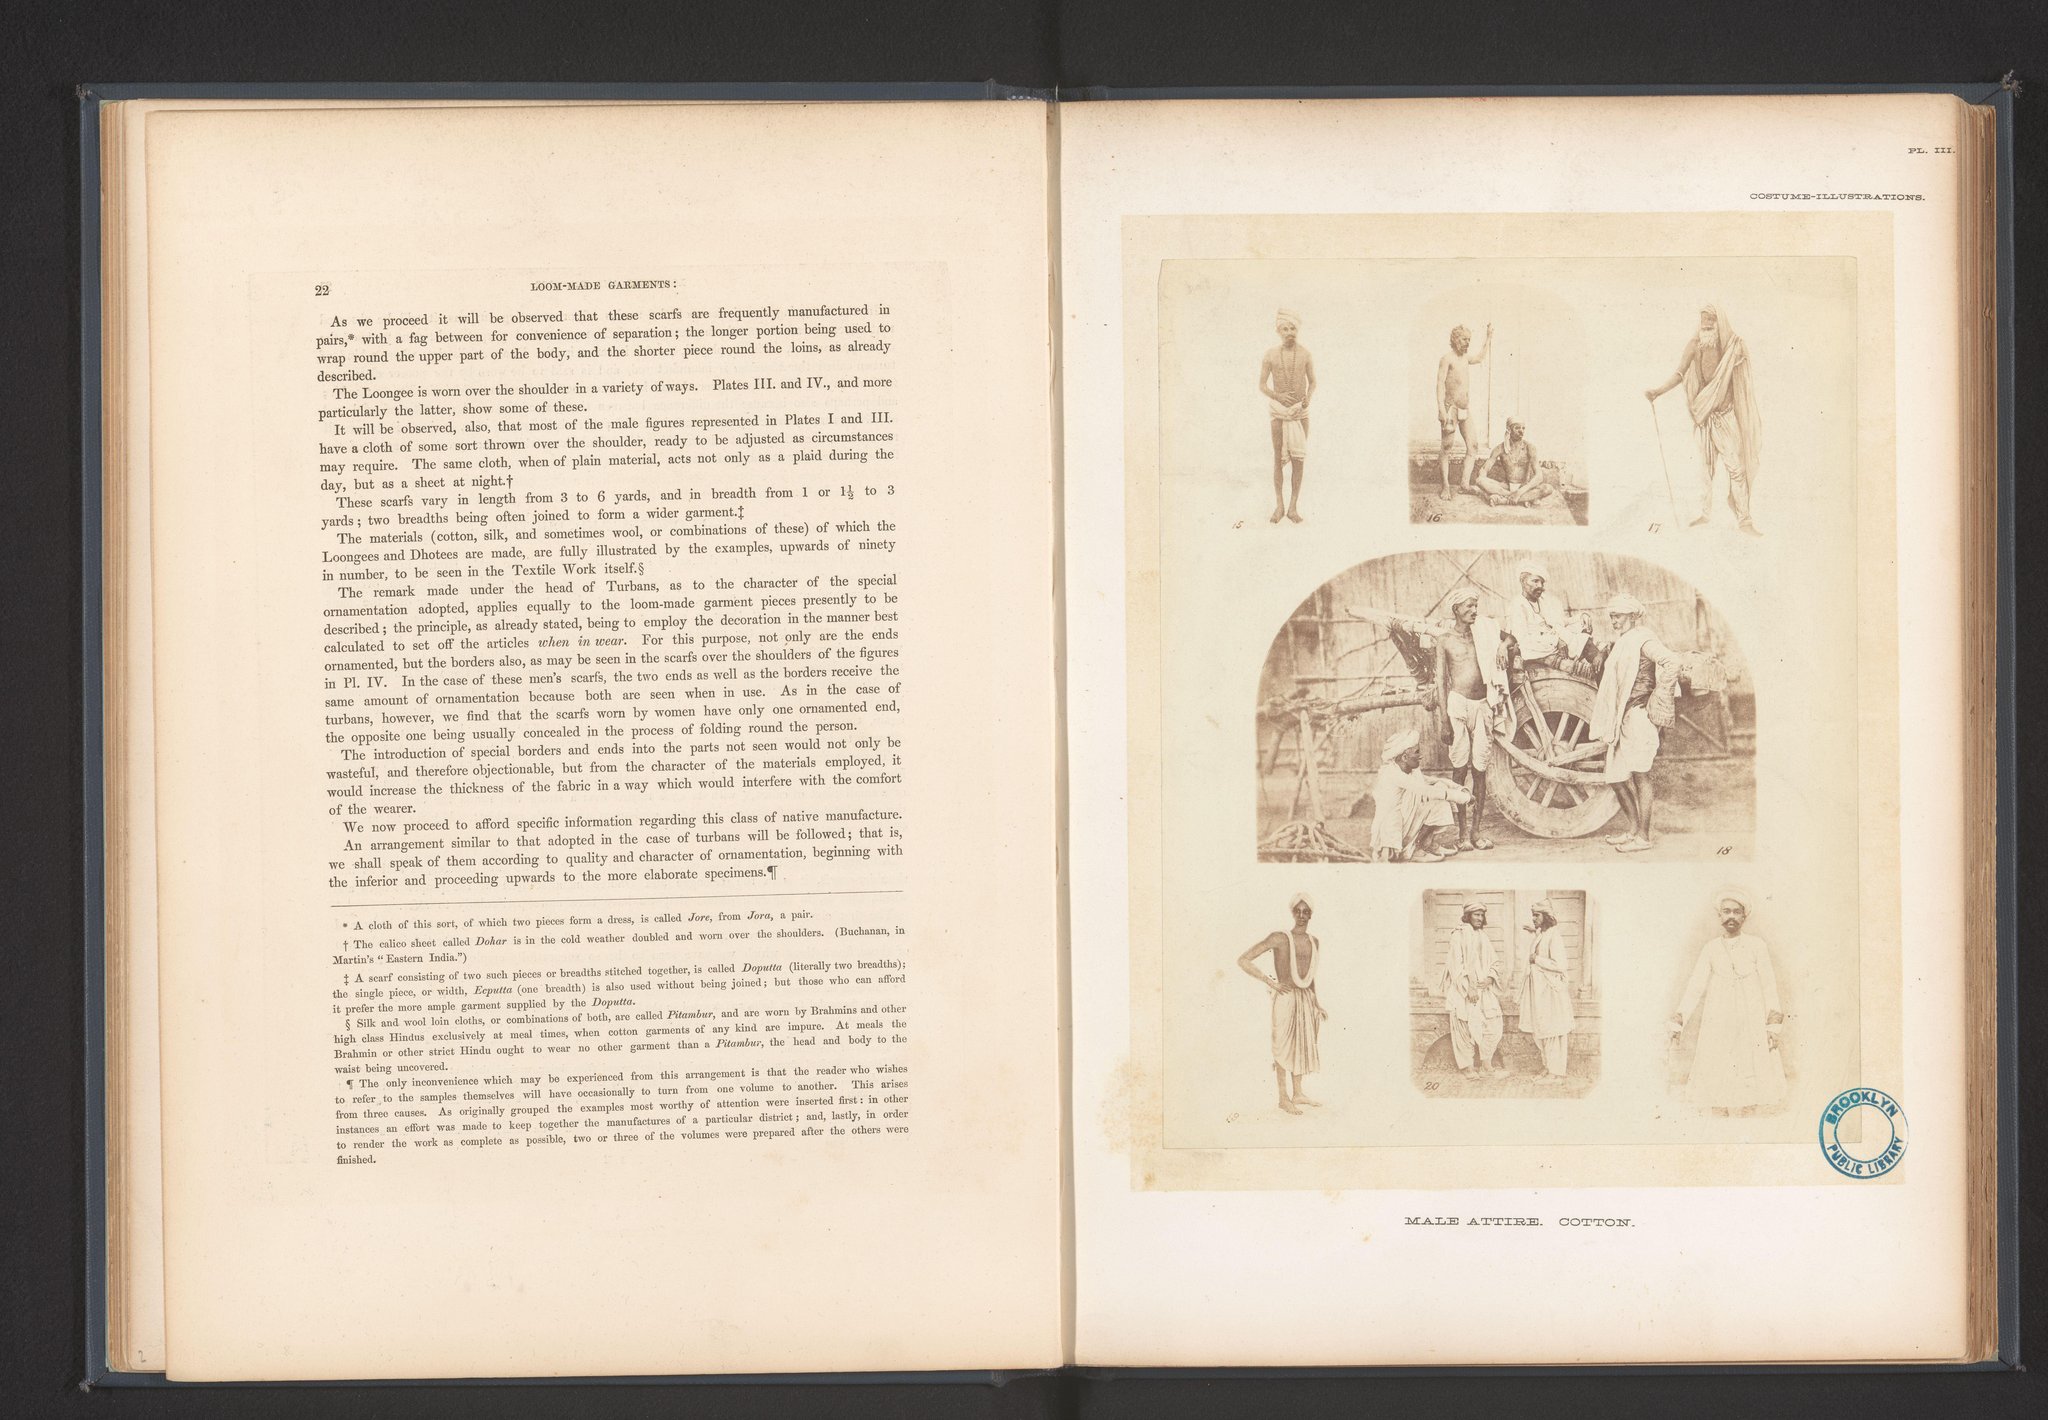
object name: photograph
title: Verzameling portretten en een gezelschap van Indiase mannen ter illustratie van verschillende mannenkleding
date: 1861-1866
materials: photographic support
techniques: albumen print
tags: fashion, clothing, historical persons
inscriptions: inscription: ‘PL. III./ Costume-Illustrations’, collector's mark: ‘Brooklyn Public Library’